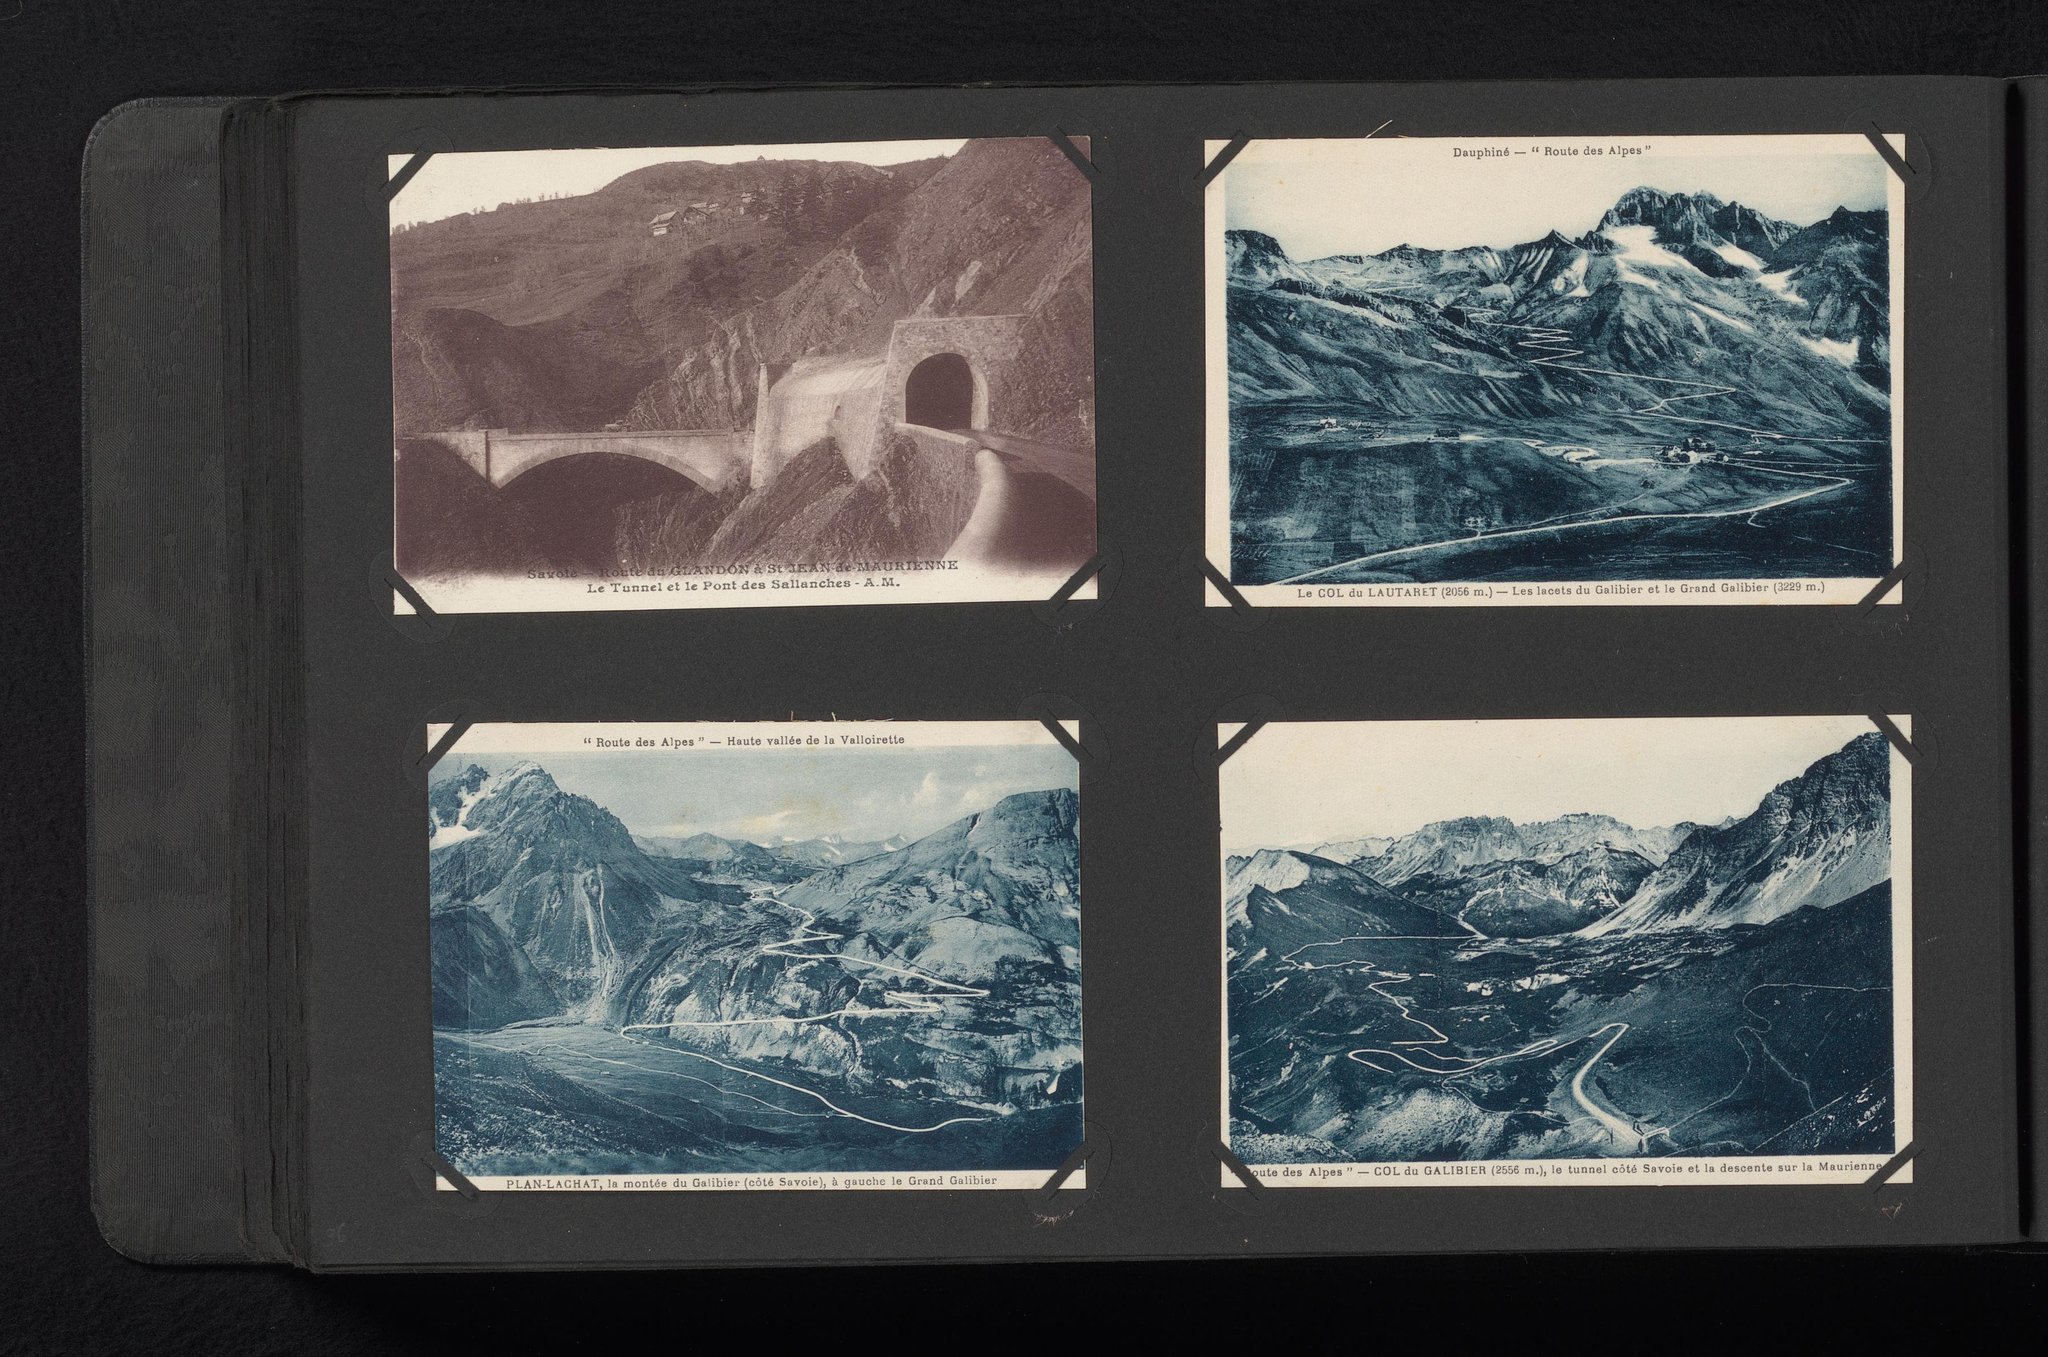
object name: ansichtkaart, prentbriefkaart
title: Vier fotomechanische prentbriefkaarten van bergen in de Savoie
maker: Anonymous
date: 1908-1929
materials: cardboard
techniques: photograph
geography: savoie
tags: mountains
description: Deze prenten maken deel uit van een album.